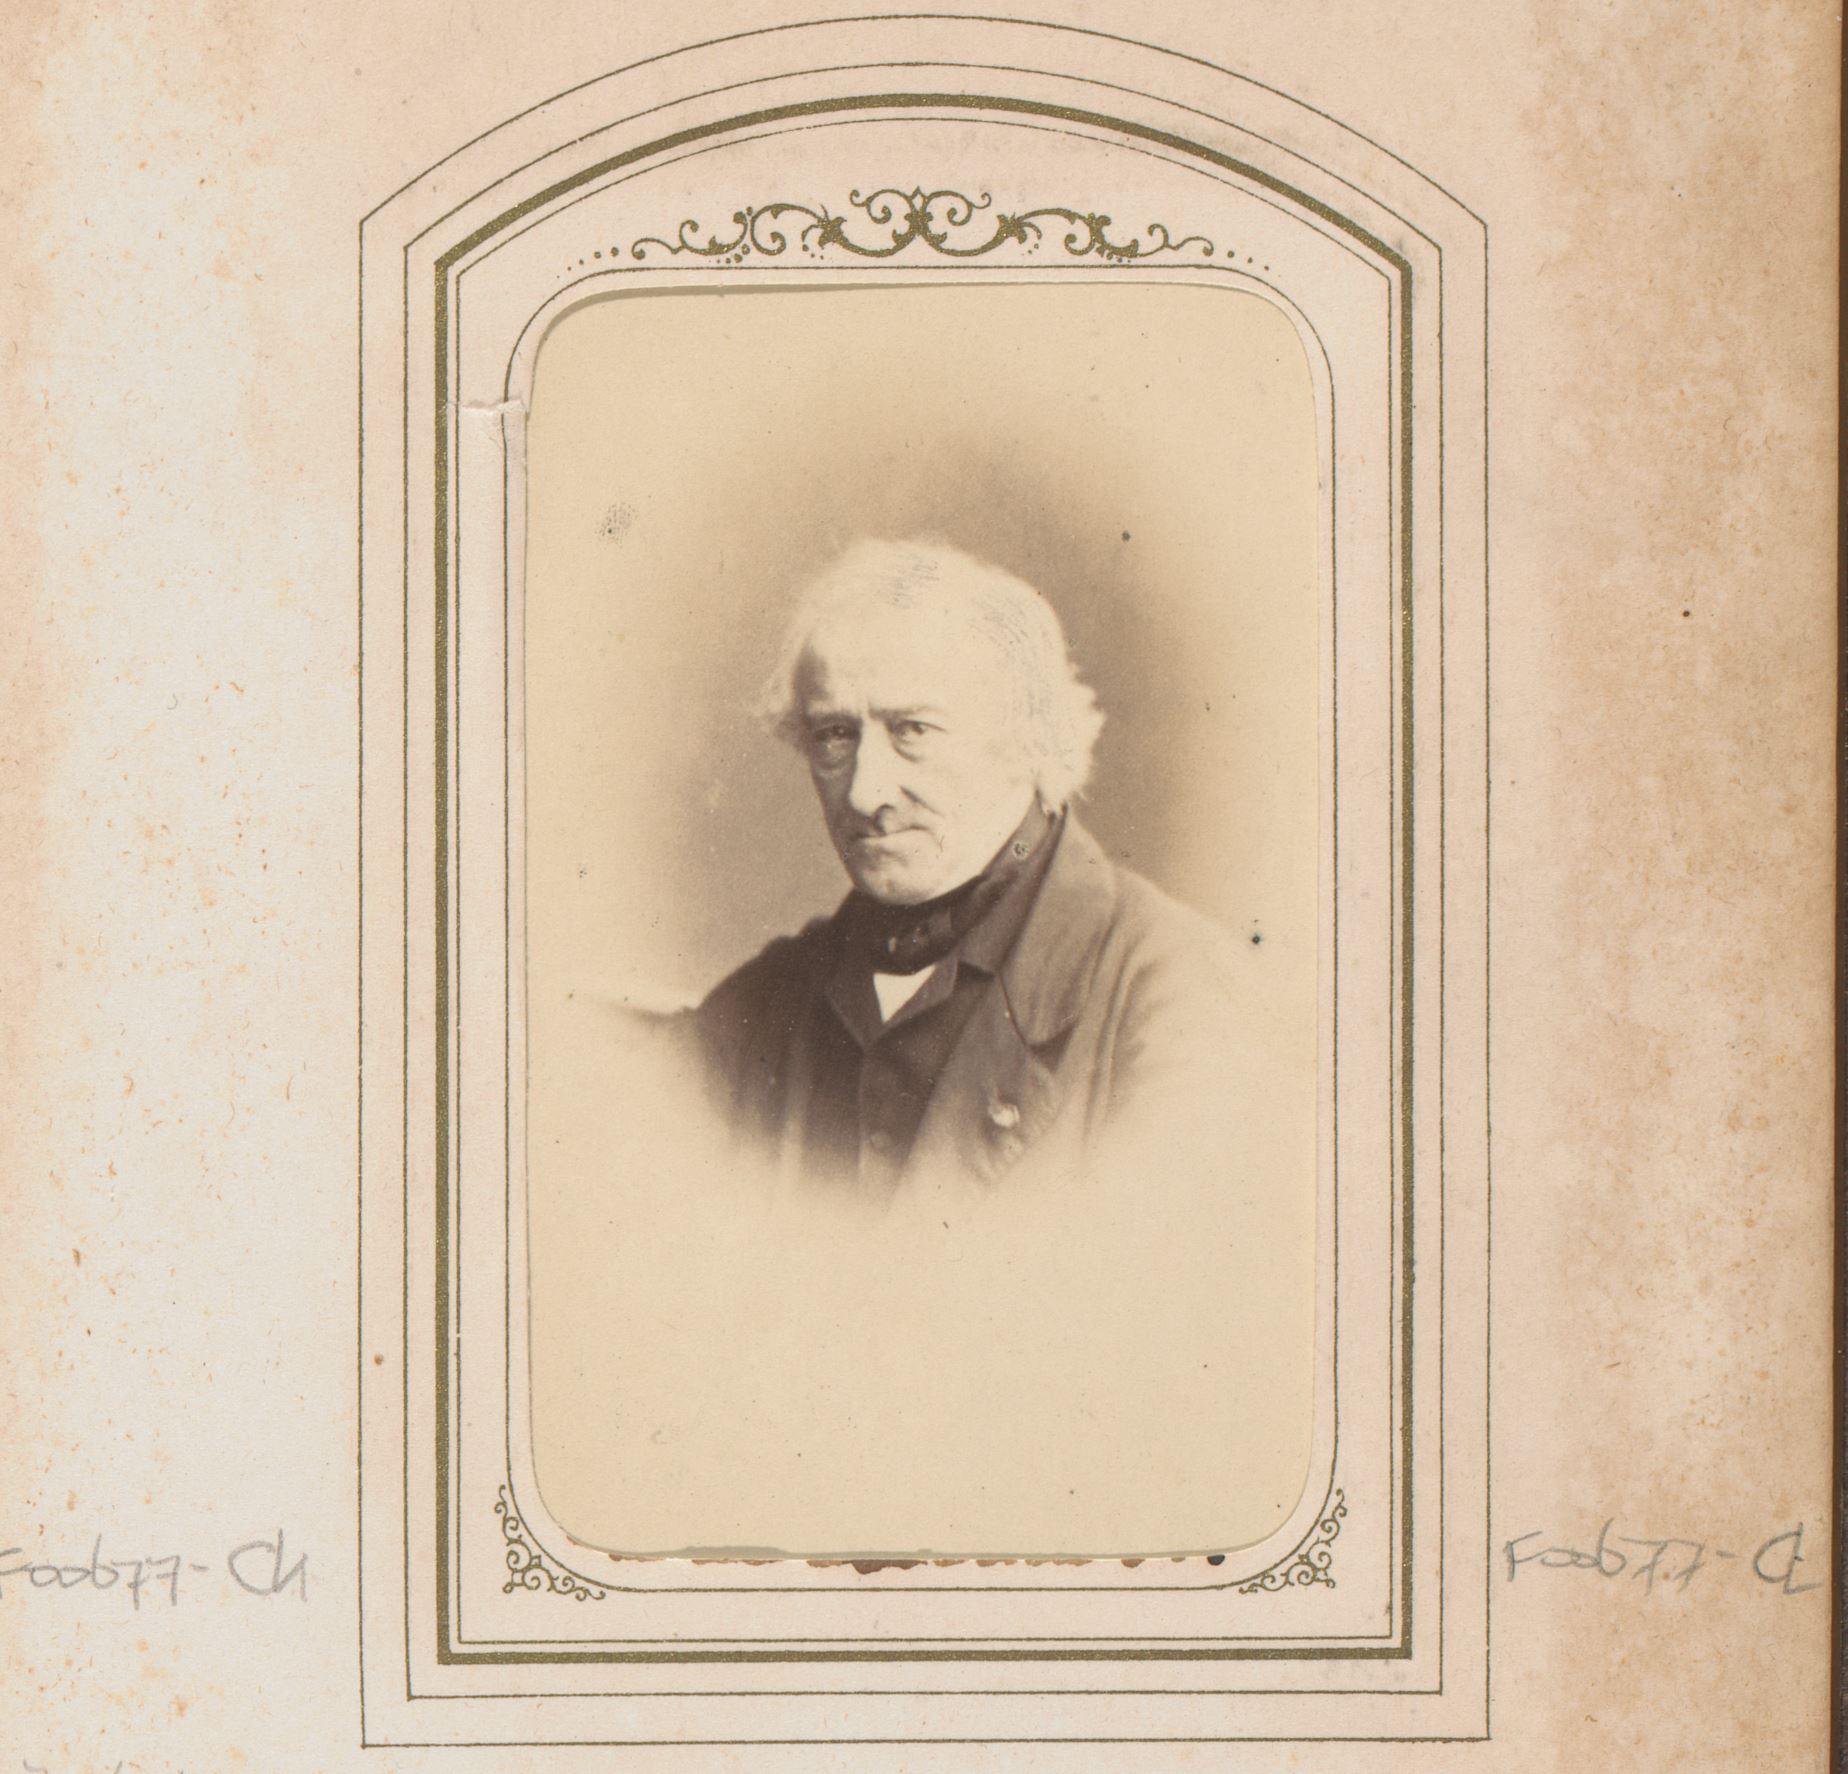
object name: album leaf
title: Portret van Jacob van Lennep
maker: maurits verveer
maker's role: painter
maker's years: 1817-1903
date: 1855-1868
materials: cardboard, photographic support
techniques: albumen print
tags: amsterdam, jacob van lennep, historical persons, portrait of a writer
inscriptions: inscription: ‘M. VERVEER/ PHOTOGRAPHE/ DE S.S.M.M. le Roi et la Reine des Pays-Bas/ 52, ZEESTRAAT, 52/ VIS A VIS DU WILLEMSPARK/ LA HAYE.’